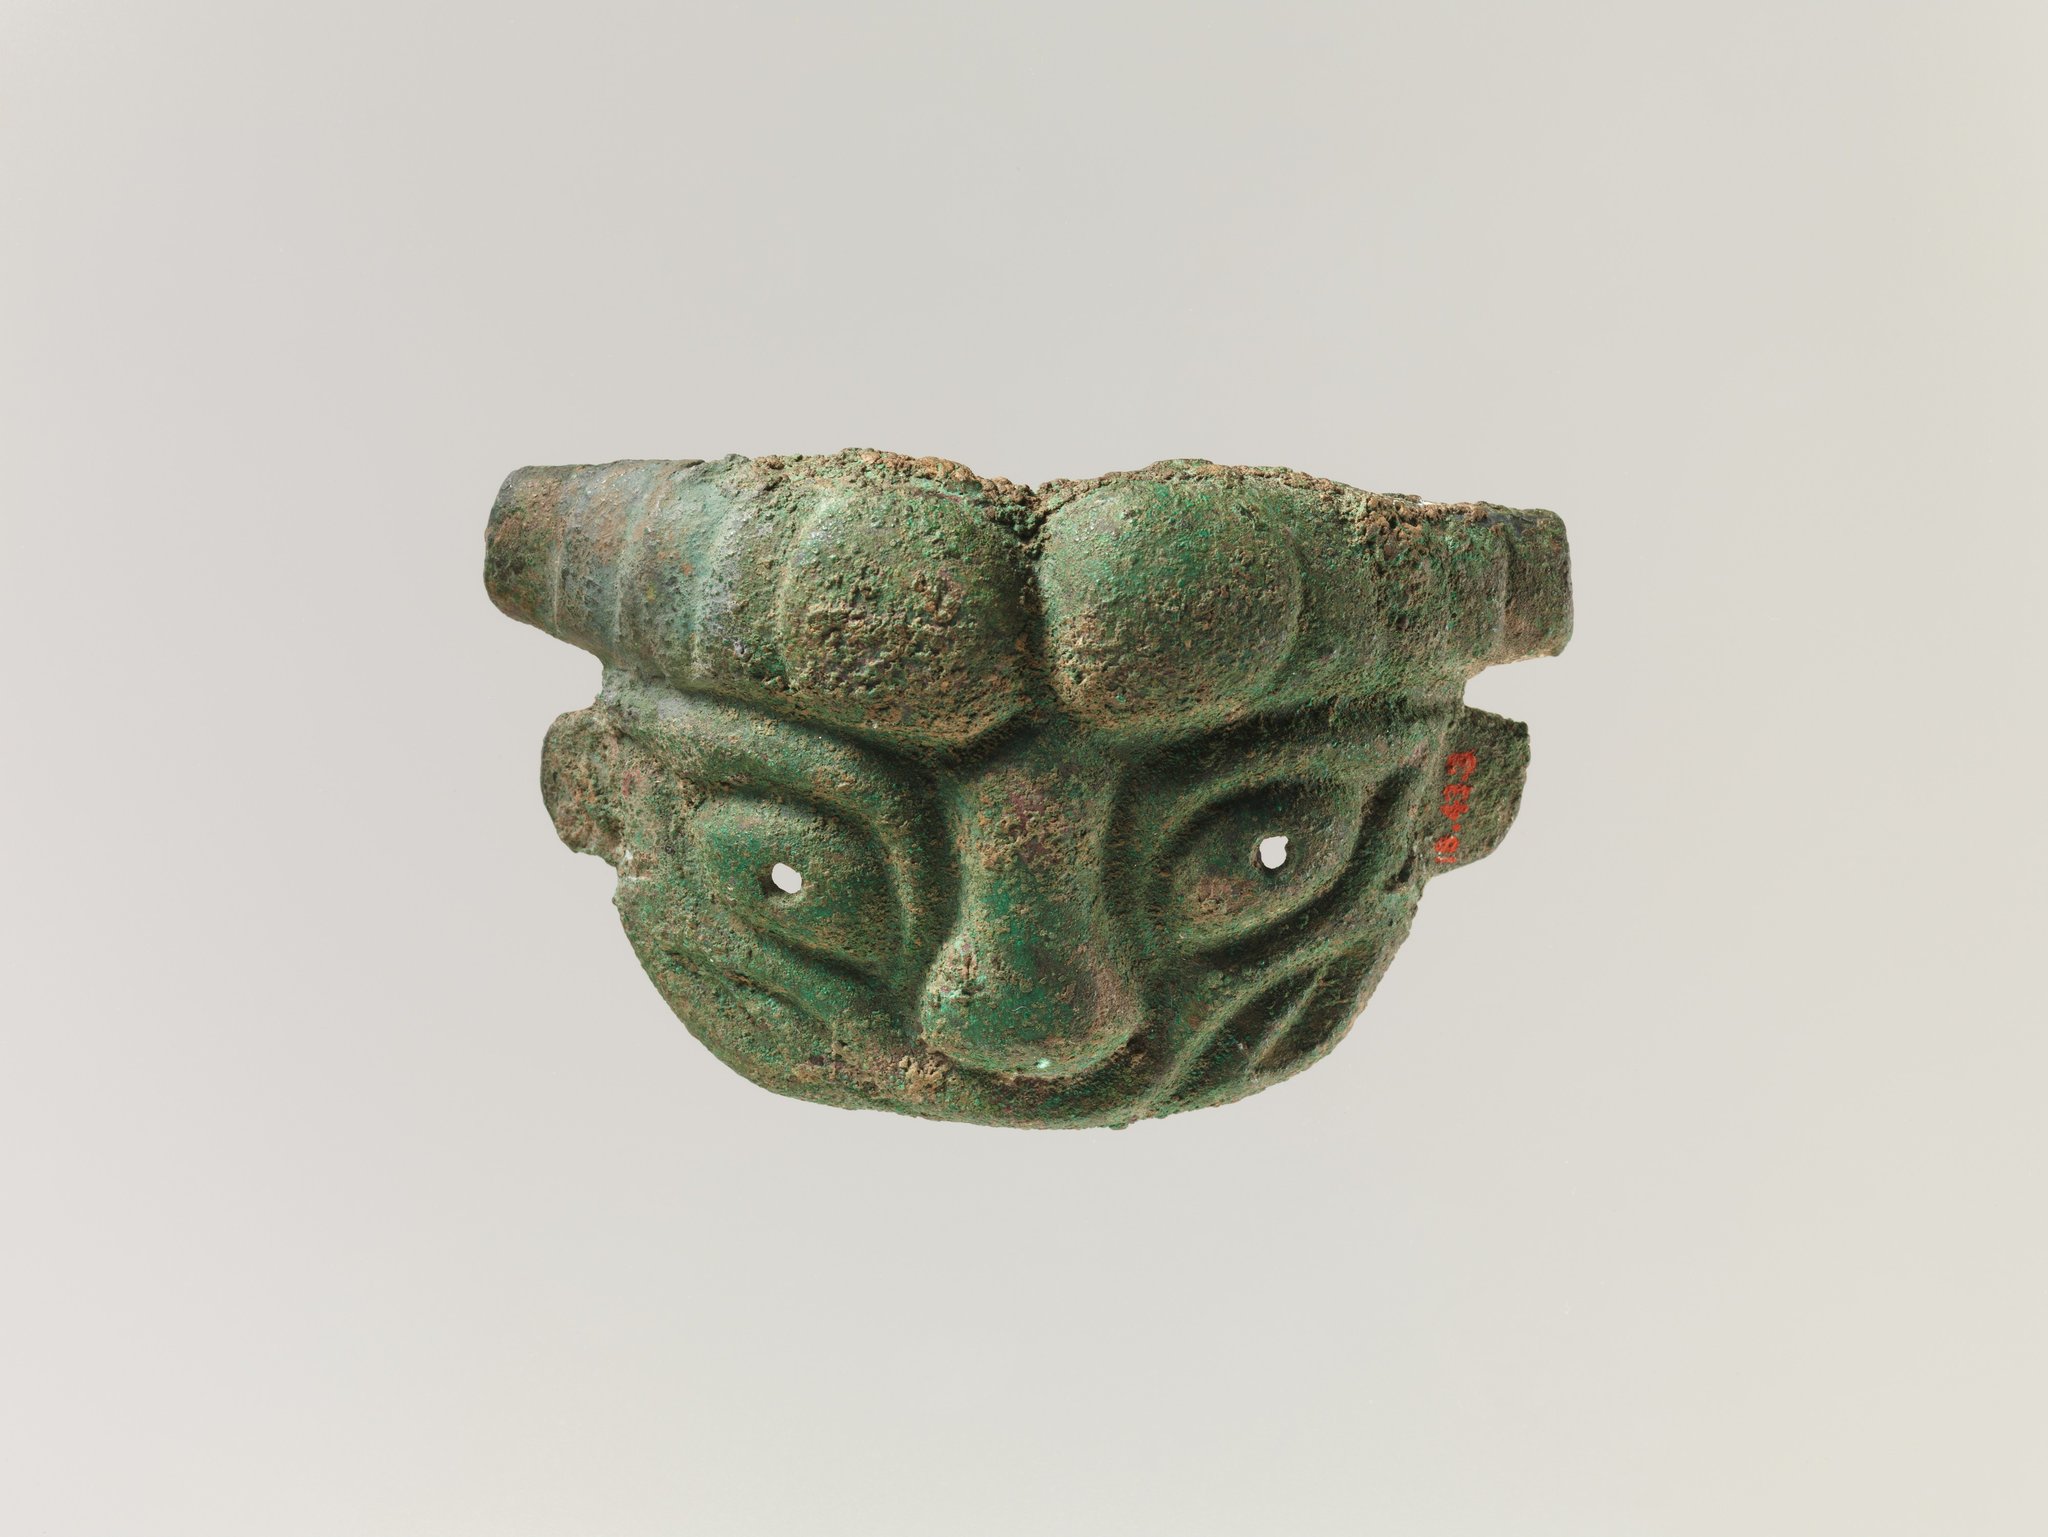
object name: fitting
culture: chinese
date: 1046-771 BCE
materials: bronze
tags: lions